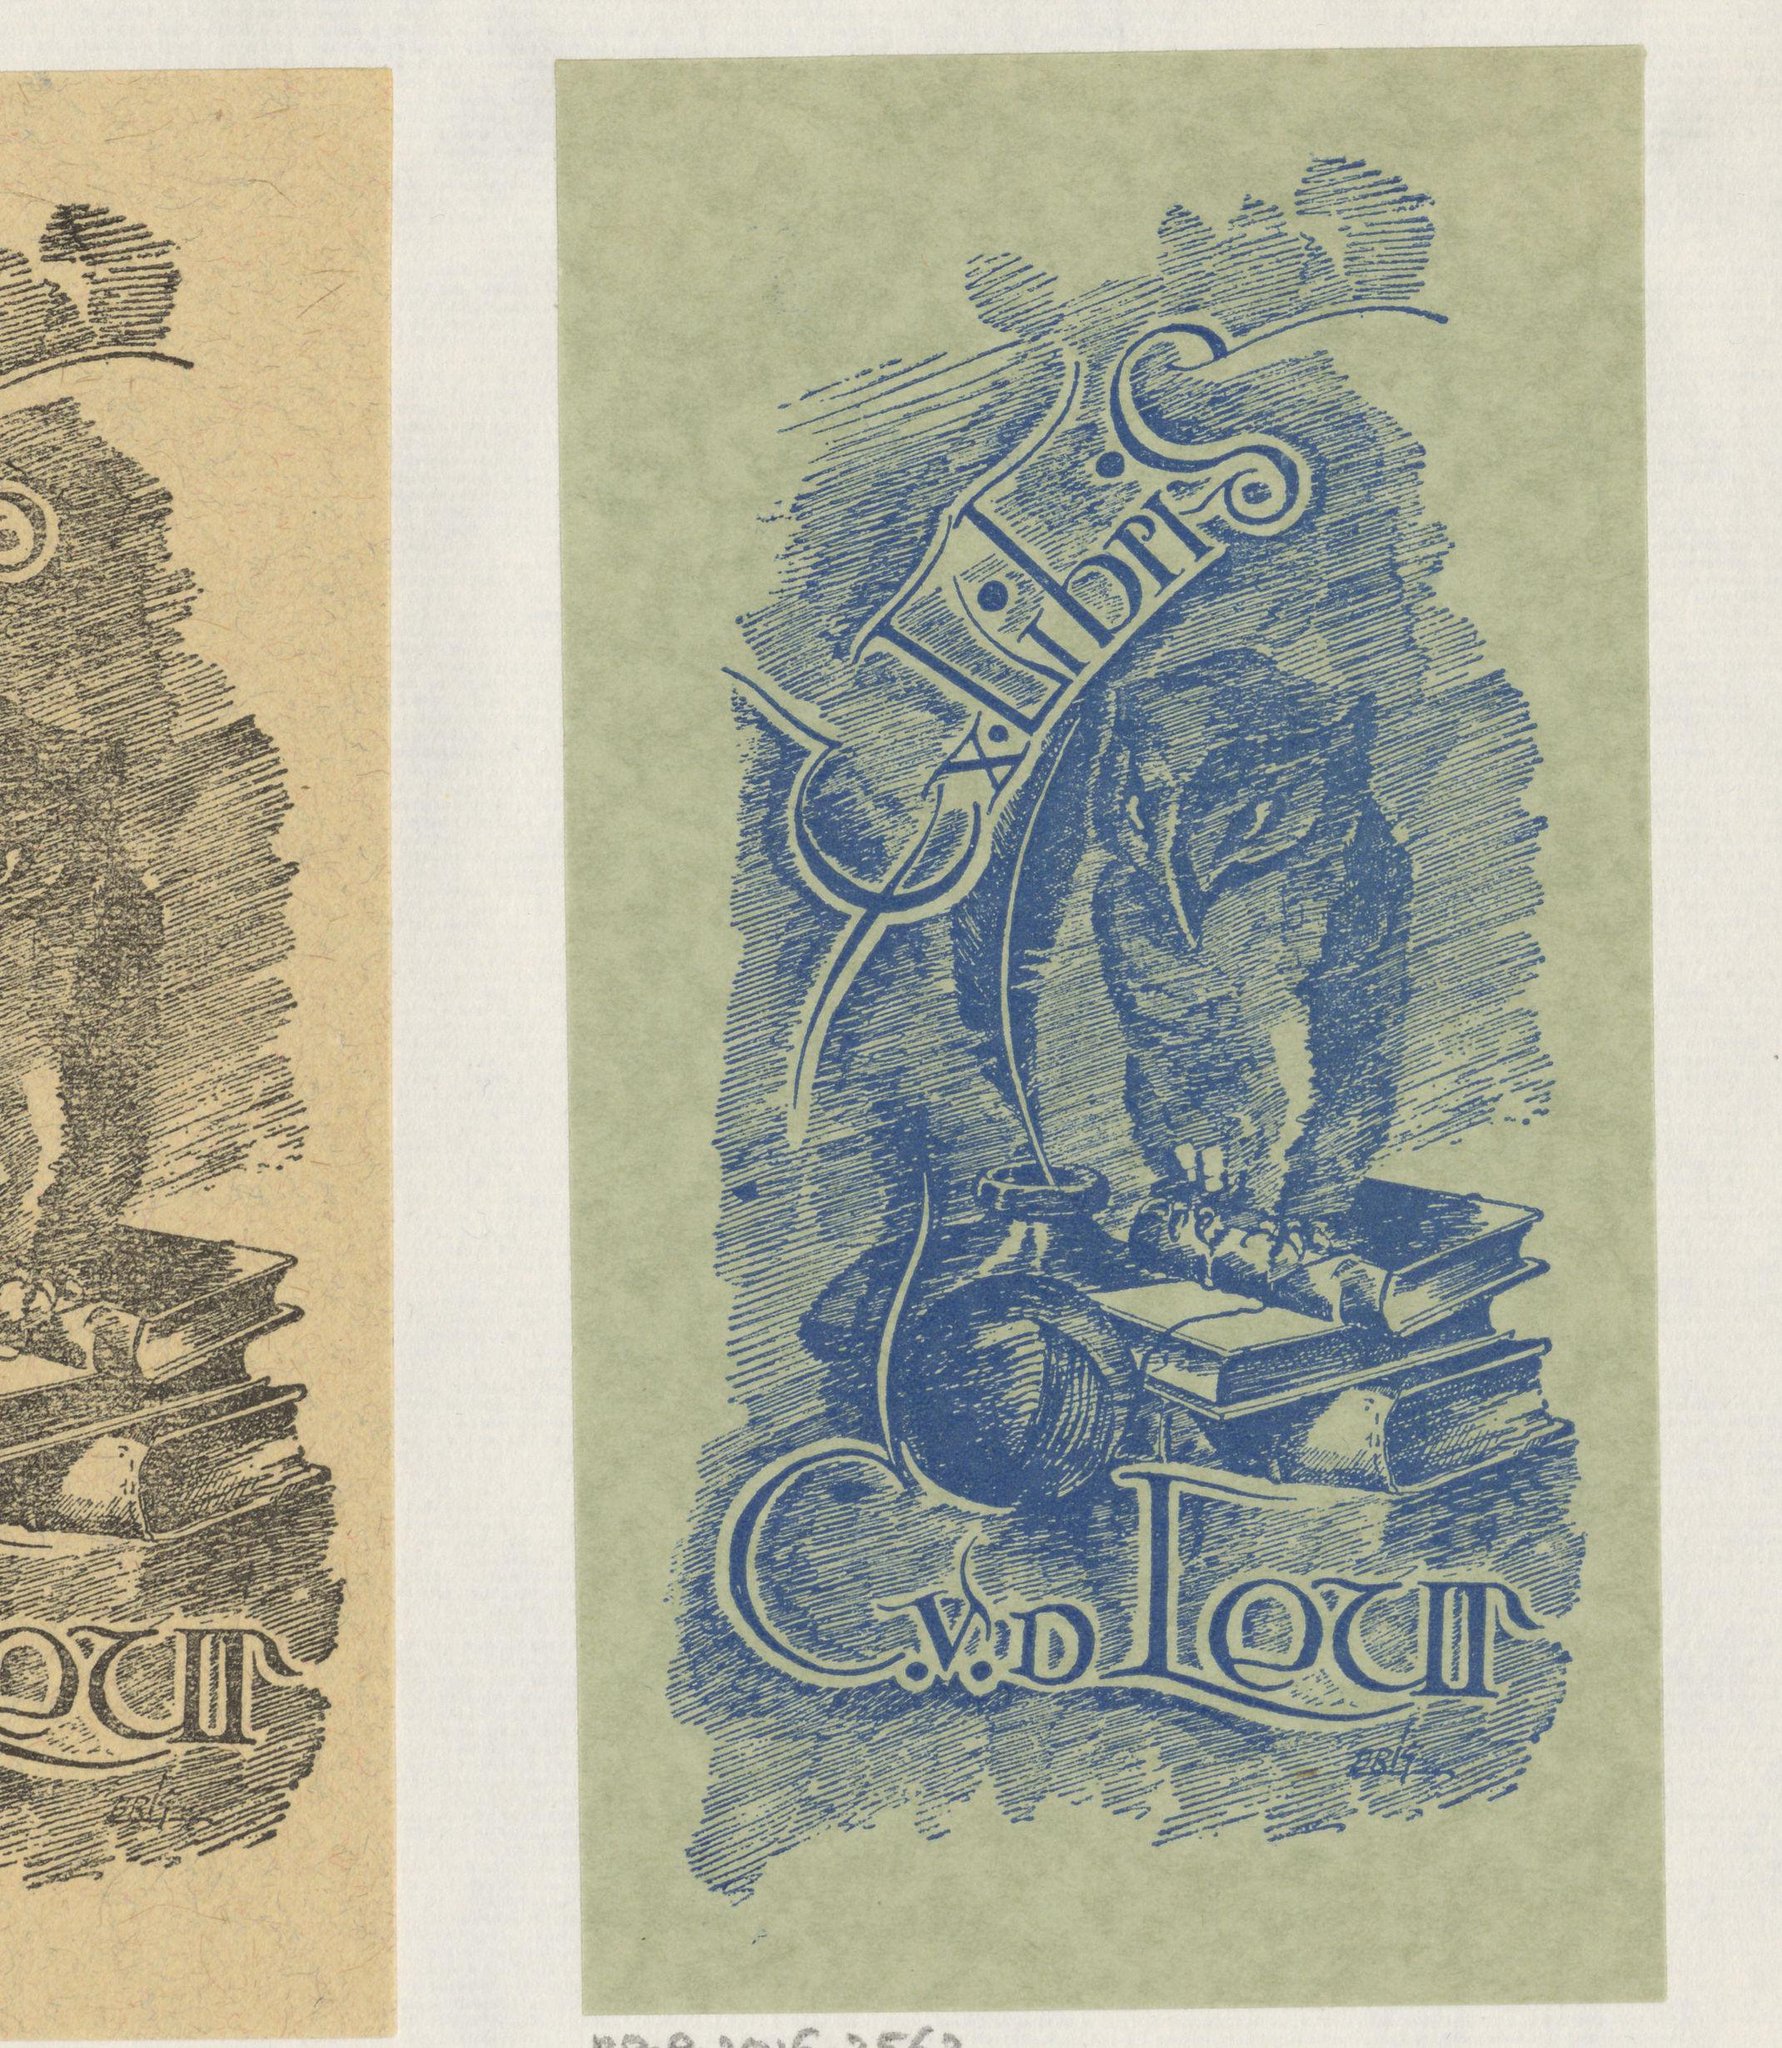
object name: bookplate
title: Ex libris van C. v.d. Leur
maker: jos van de leur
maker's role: print maker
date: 1948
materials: paper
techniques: printing block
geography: netherlands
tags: quill, ink-well, owls